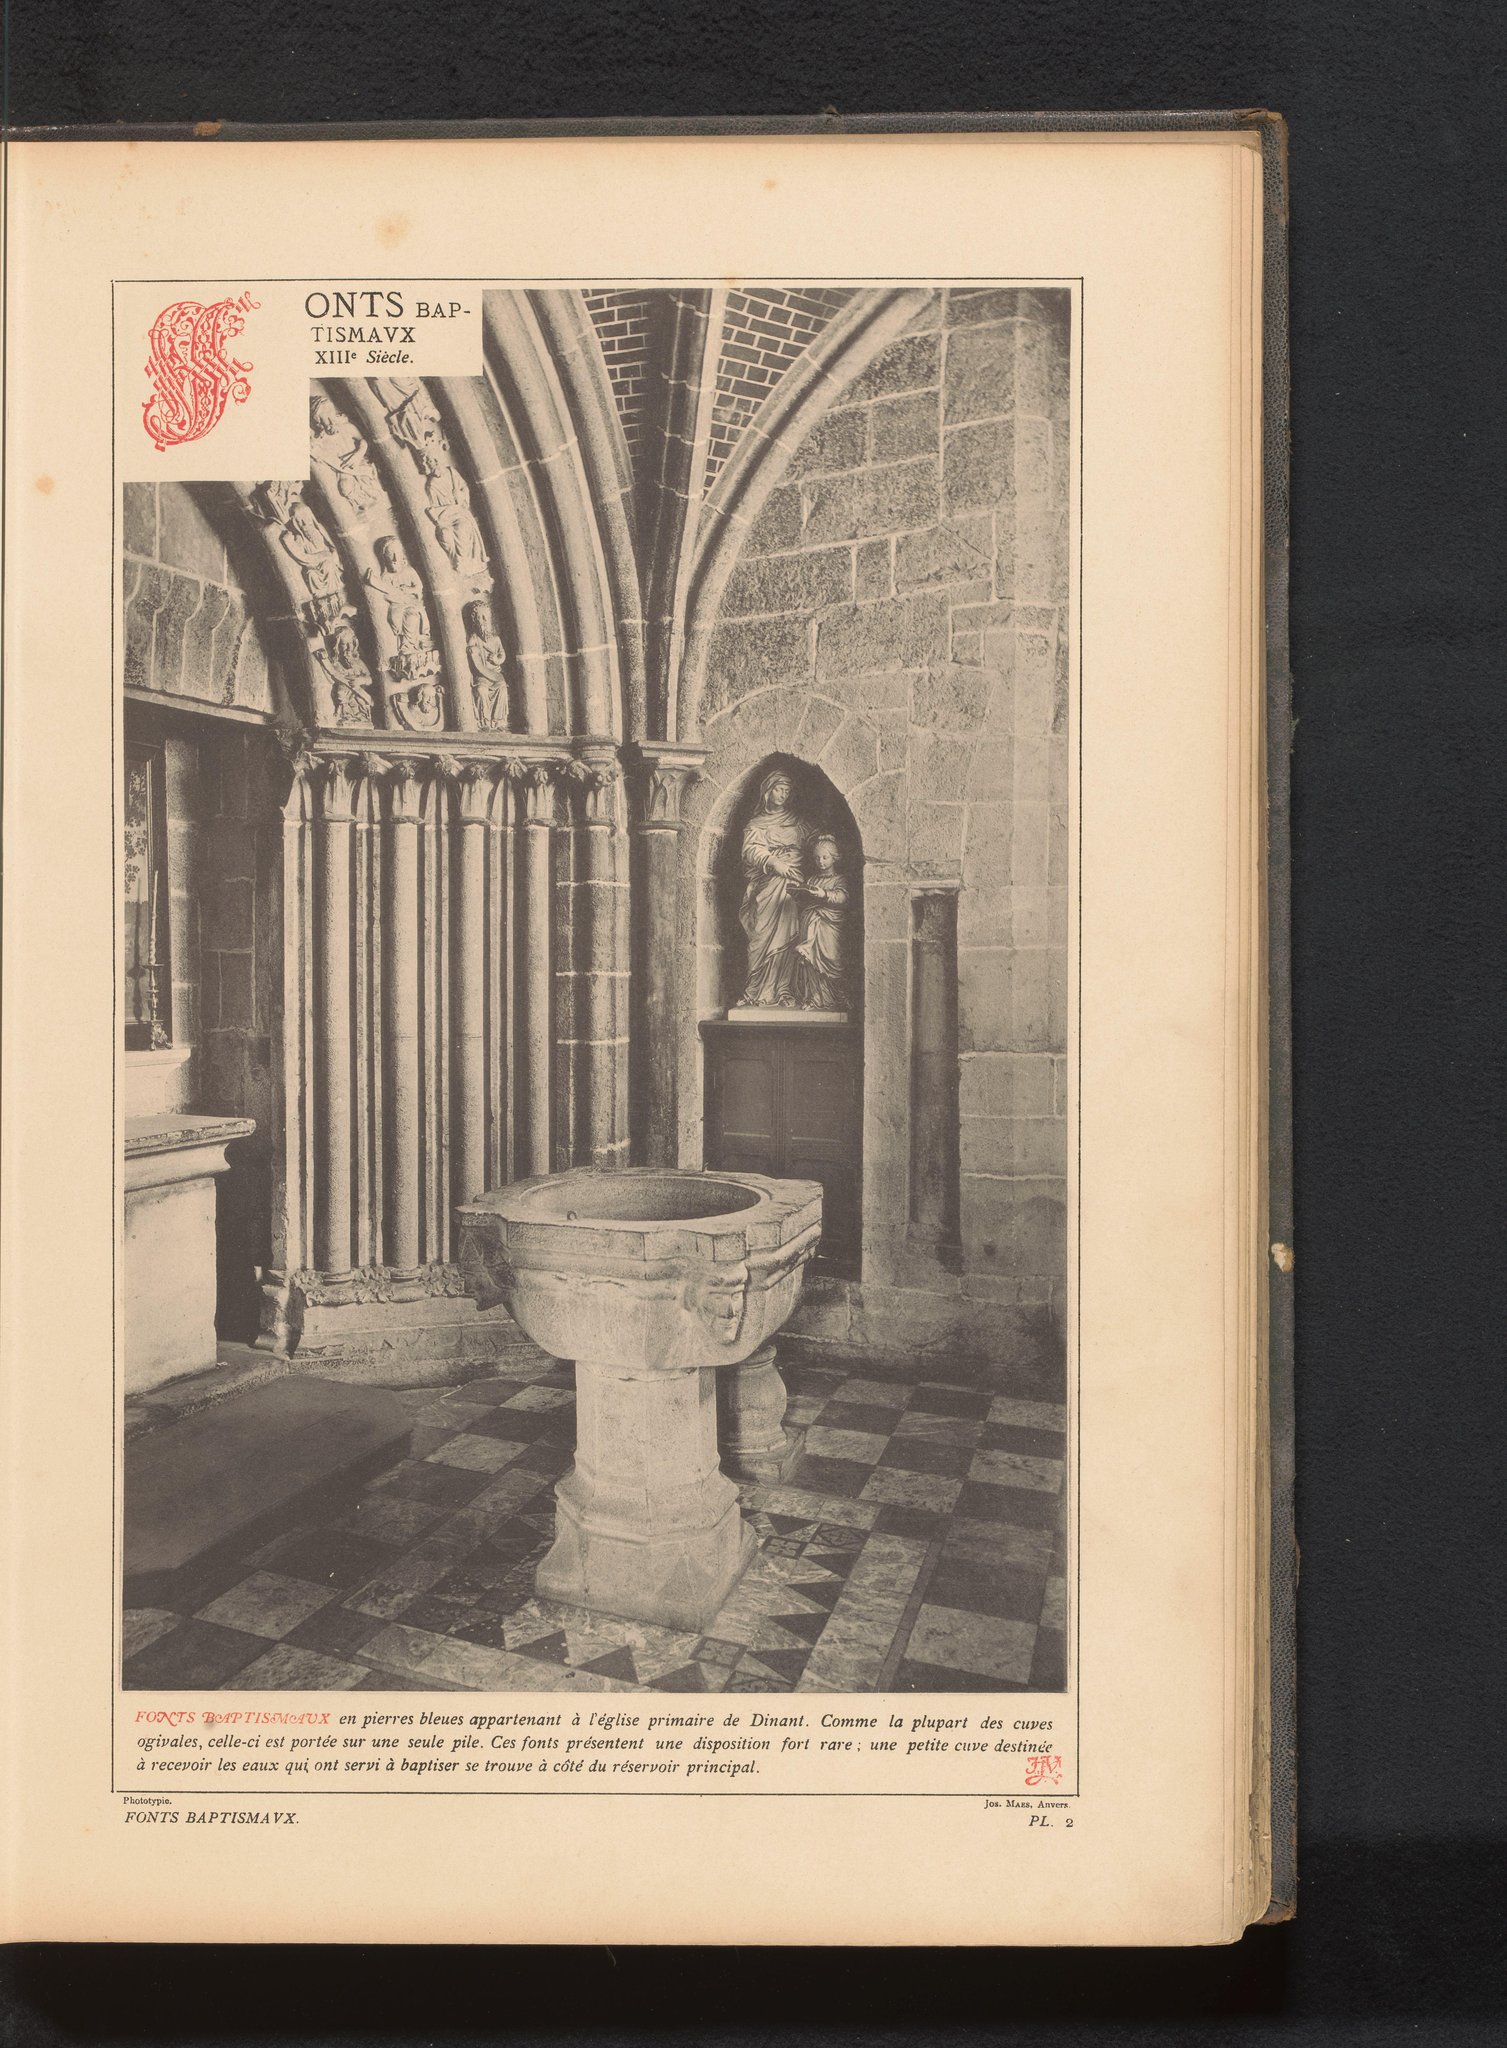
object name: photomechanical print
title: Fonts baptismaux, XIIIe Siècle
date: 1881-1889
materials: paper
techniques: photograph, photolithography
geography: antwerp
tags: interior of church, baptismal font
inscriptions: inscription: ‘FONTS BAPTISMAUX en pierres (...)’, monogram: ‘JJvY’, inscription: ‘FONTS BAPTISMAUX. PL. 2.’